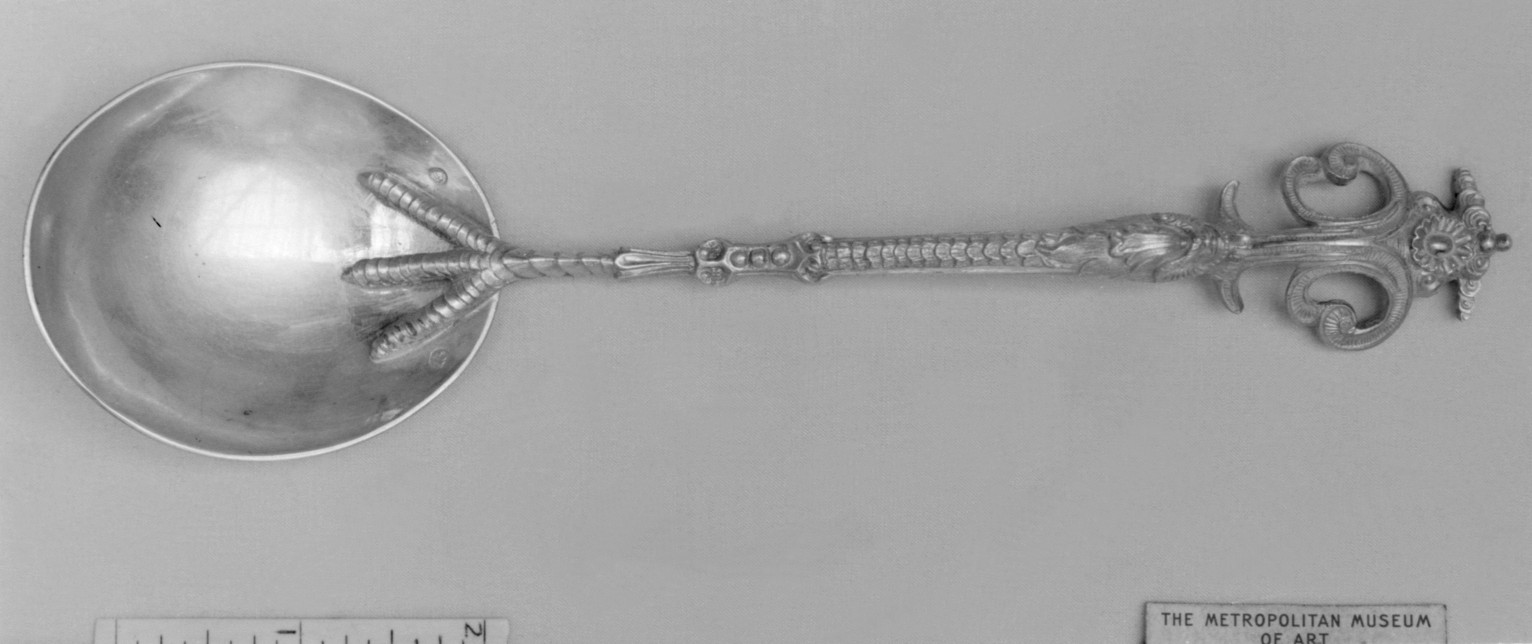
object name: spoon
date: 1801-1900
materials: silver gilt